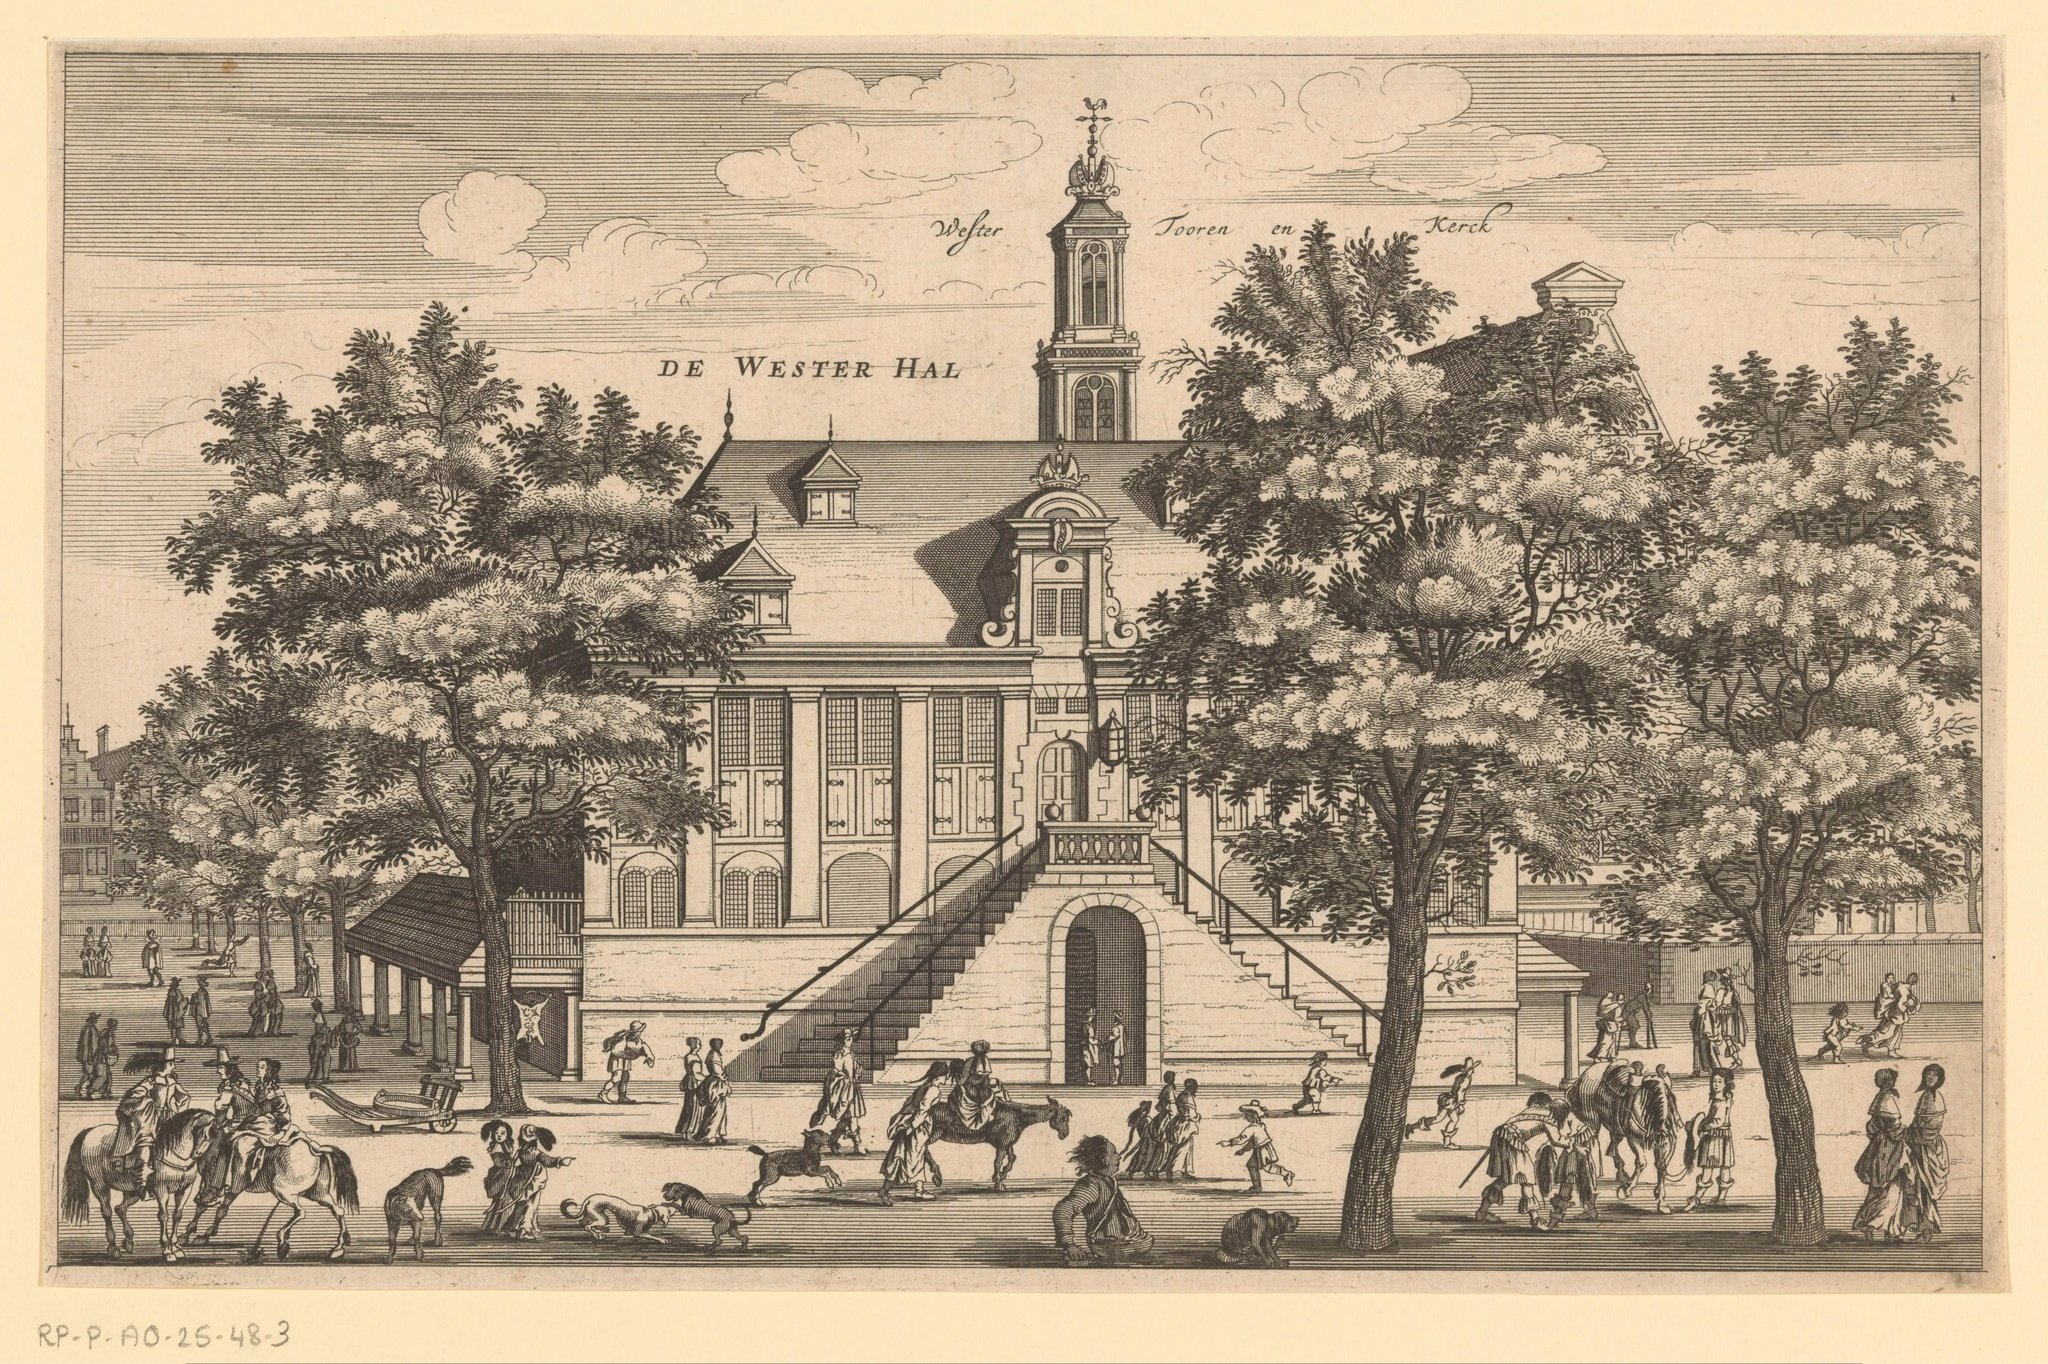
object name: book illustration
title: De Wester Hal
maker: jacob van meurs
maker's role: draughtsman, print maker, publisher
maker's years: 1619-1680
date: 1663-1664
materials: paper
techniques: engraving, etching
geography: amsterdam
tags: church (exterior), market, market-hall, street (+ city(-scape) with figures, staffage), parts of church exterior and annexes: tower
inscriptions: collector's mark: Lugt 195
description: Huidige staat van prent ook gebruikt in: Dapper, Olfert. Historische beschryving der stadt Amsterdam: waer in de voornaemste geschiedenissen (na een kort verhael van gansch Hollant en d'omleggende dorpen (…). Amsterdam: Jacob van Meurs, 1663.* En in: Zesen, Philipp von. Beschreibung der Stadt Amsterdam: darinnen von derselben ersten Ursprunge bis auf gegenwärtigen Zustand (…). Amsterdam: Joachim Nosche, 1664. * In sommige exemplaren van deze uitgave komt de huidige staat van de prent voor. In andere exemplaren is een latere staat ingebonden, waarop boven de Nederlandse een Franse titel is toegevoegd.